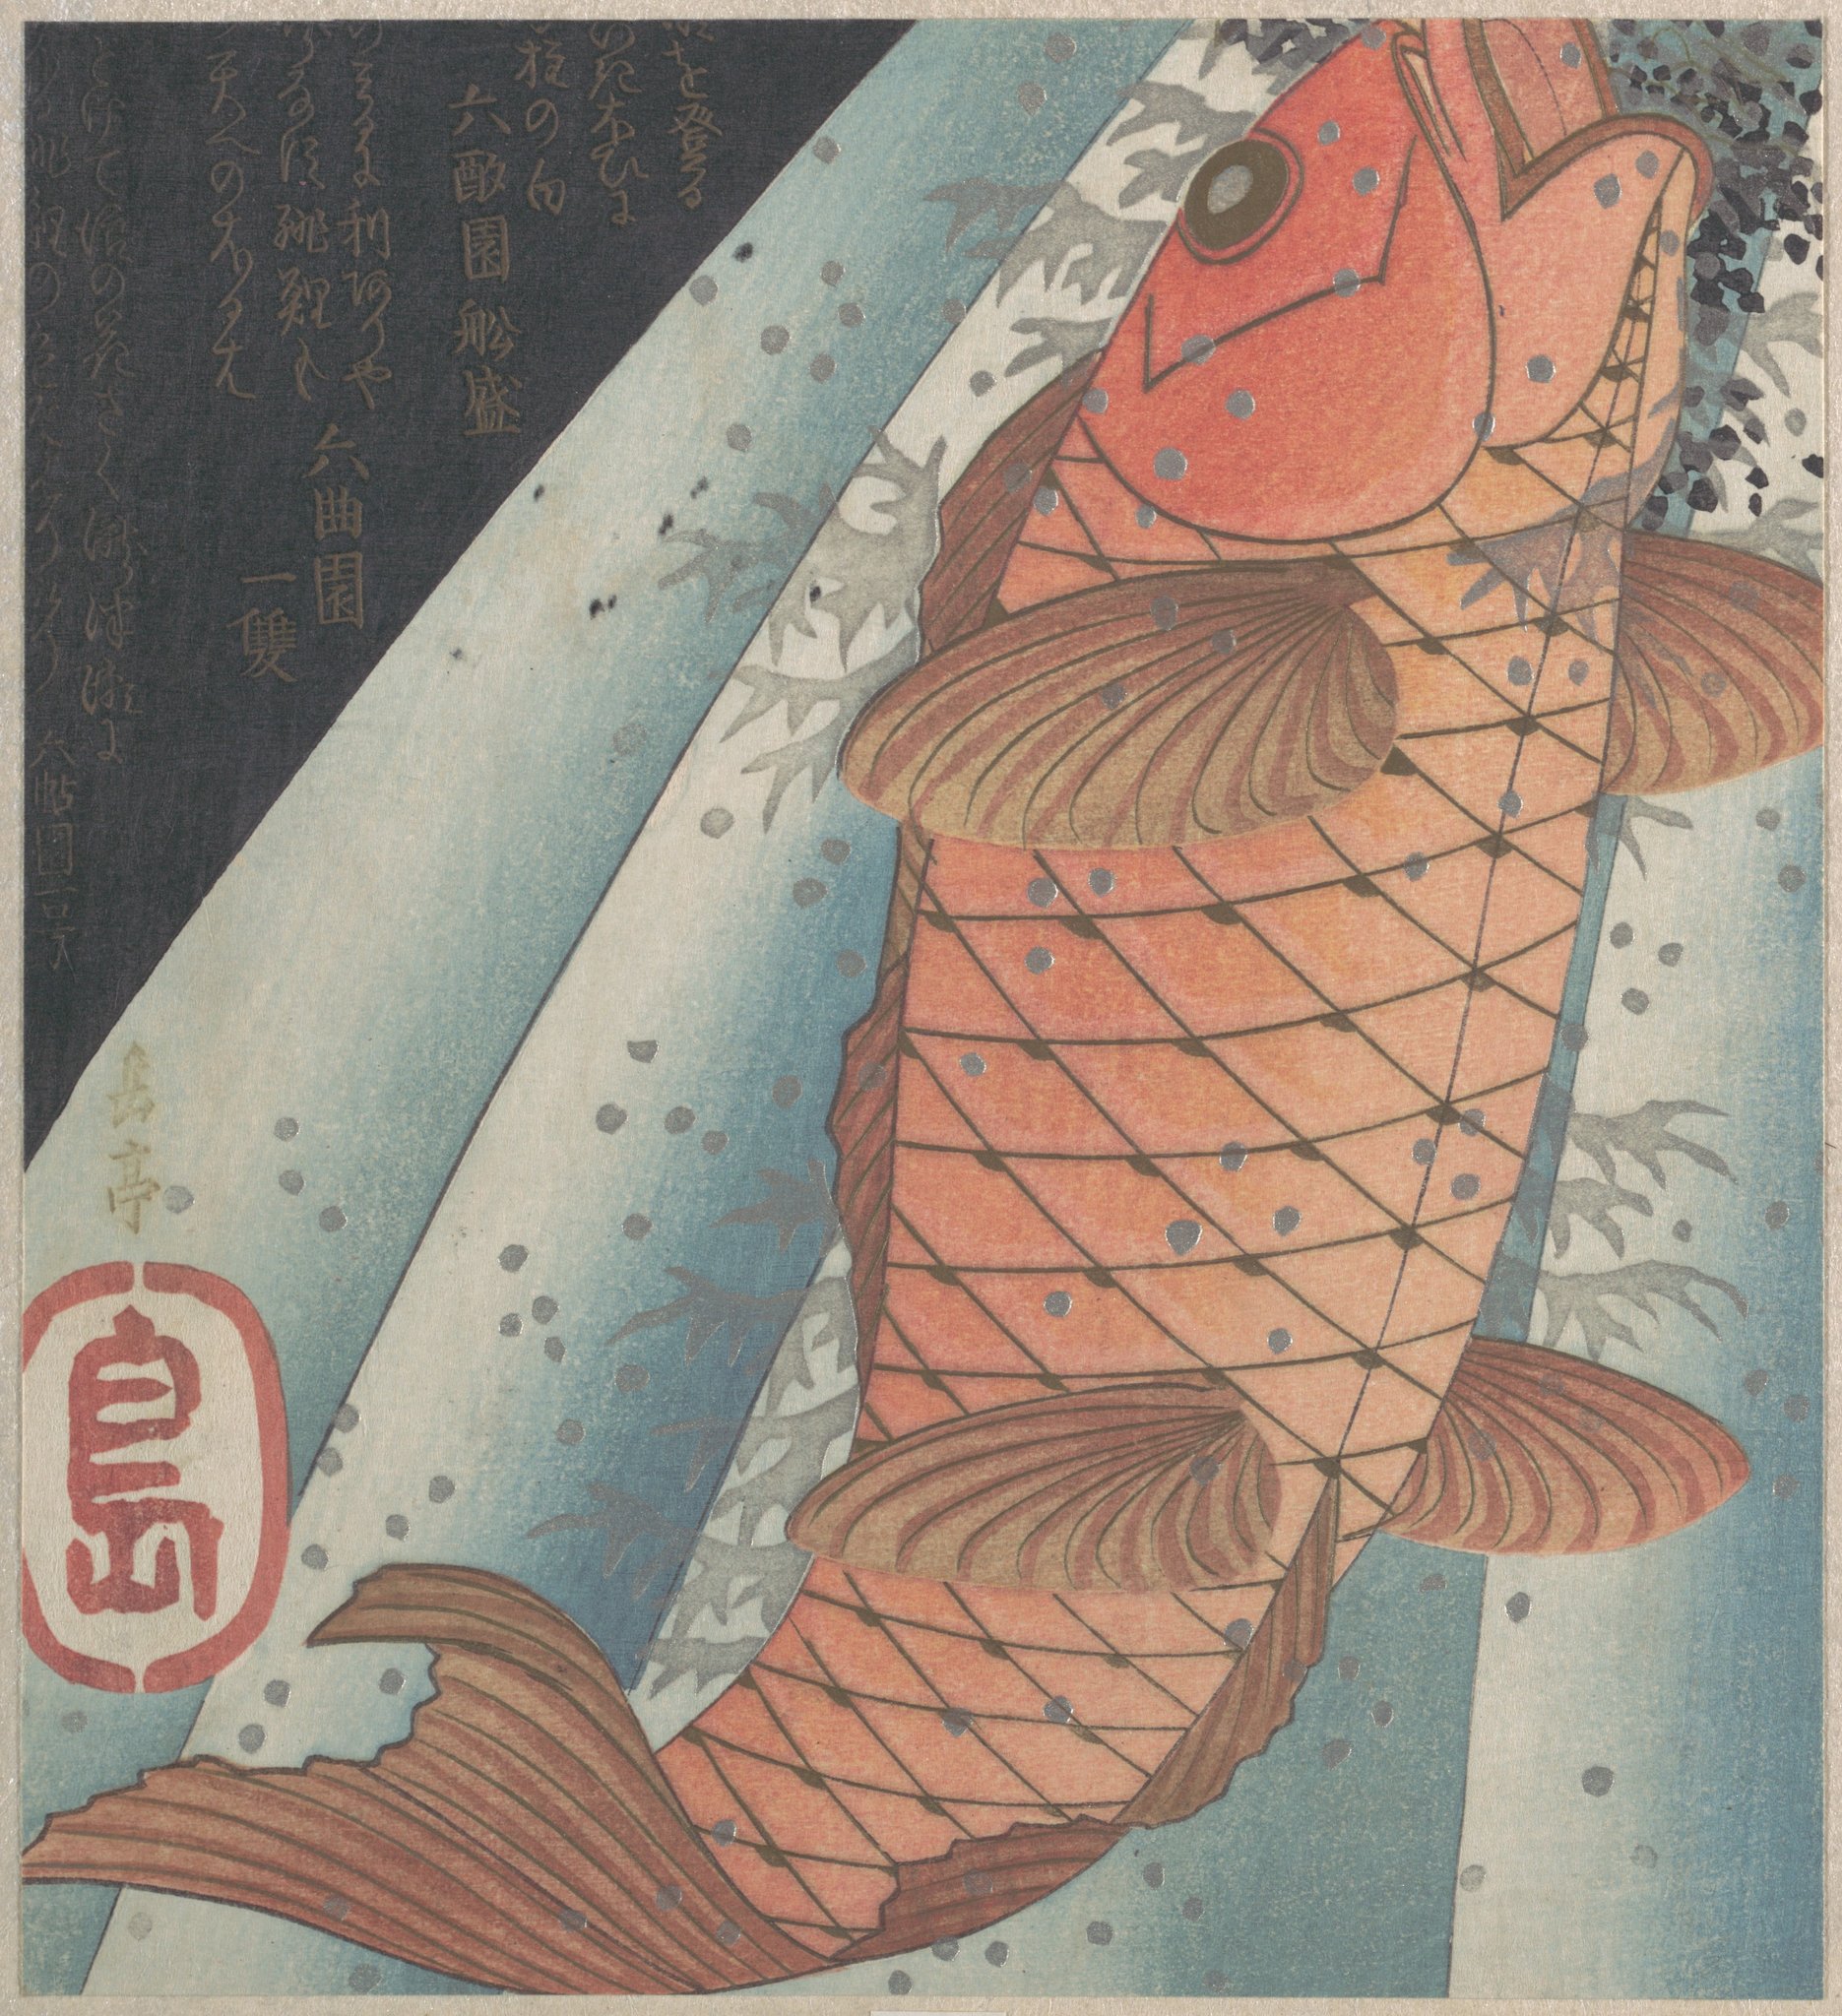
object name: woodblock print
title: Red Carp Ascending a Waterfall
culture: japanese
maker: yashima gakutei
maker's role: artist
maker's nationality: japanese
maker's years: 1786-1868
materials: ink, paper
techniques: surimono, woodblock print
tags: fish